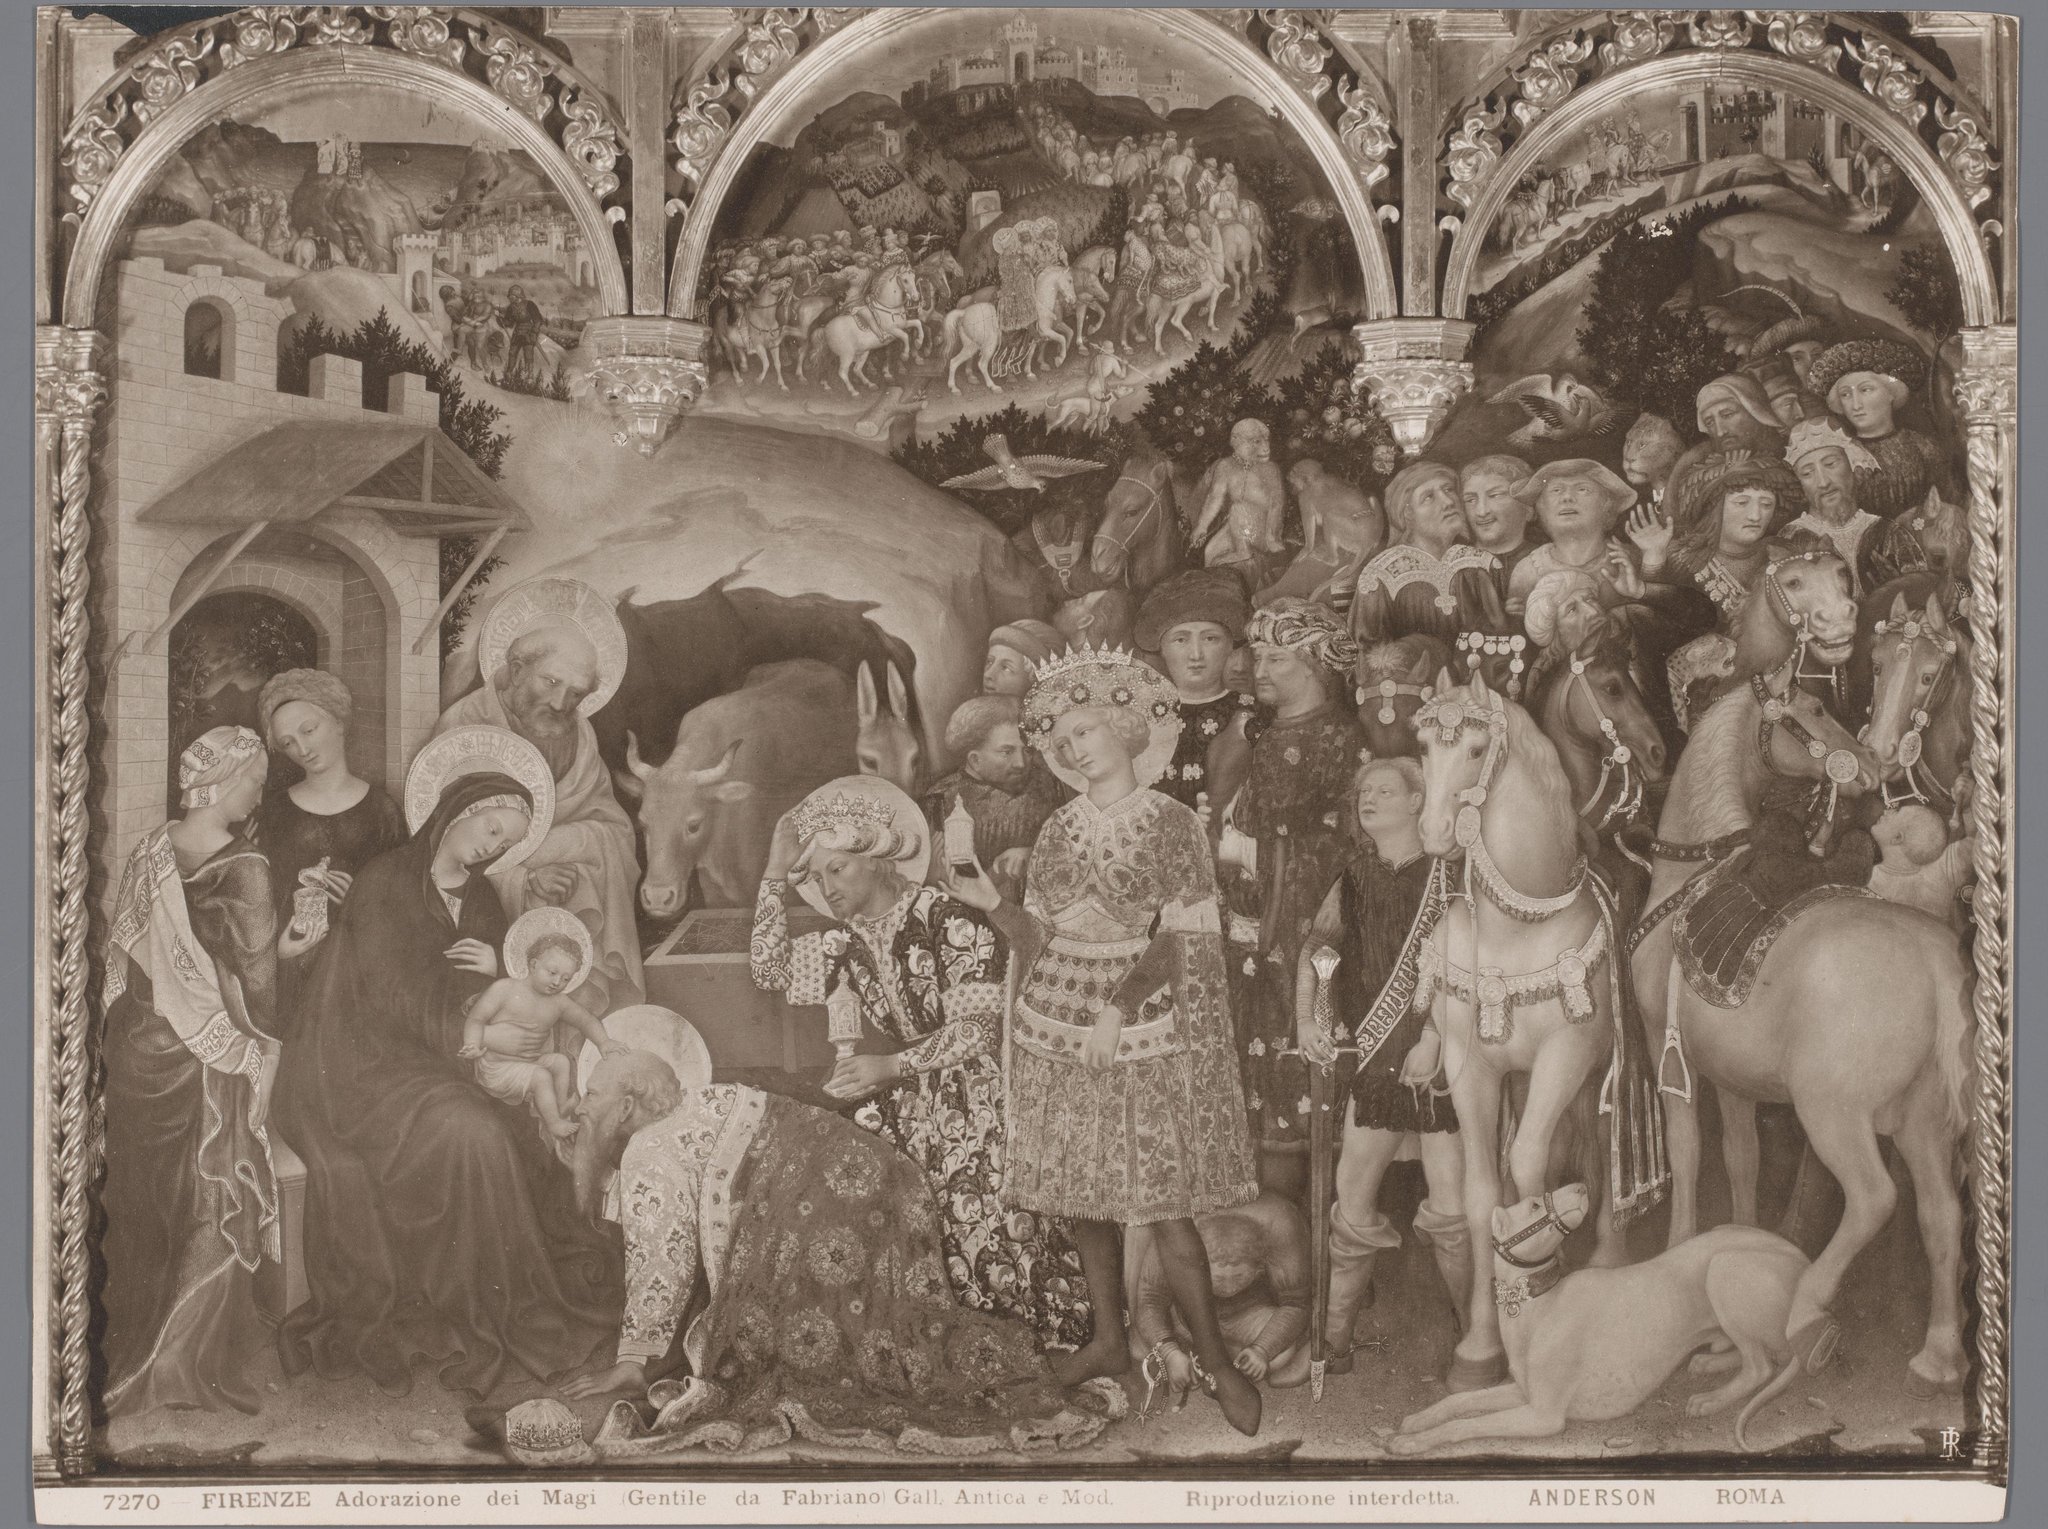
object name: reproduction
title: Fotoreproductie van het schilderij Aanbidding der Wijzen door Gentile da Fabriano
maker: gentile da fabriano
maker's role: painter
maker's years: 1370-1427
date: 1885-1930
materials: paper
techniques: gelatin silver print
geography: rome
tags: adoration of the christ-child ~ christ's birth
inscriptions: initials: ‘JR’, number: ‘7270’